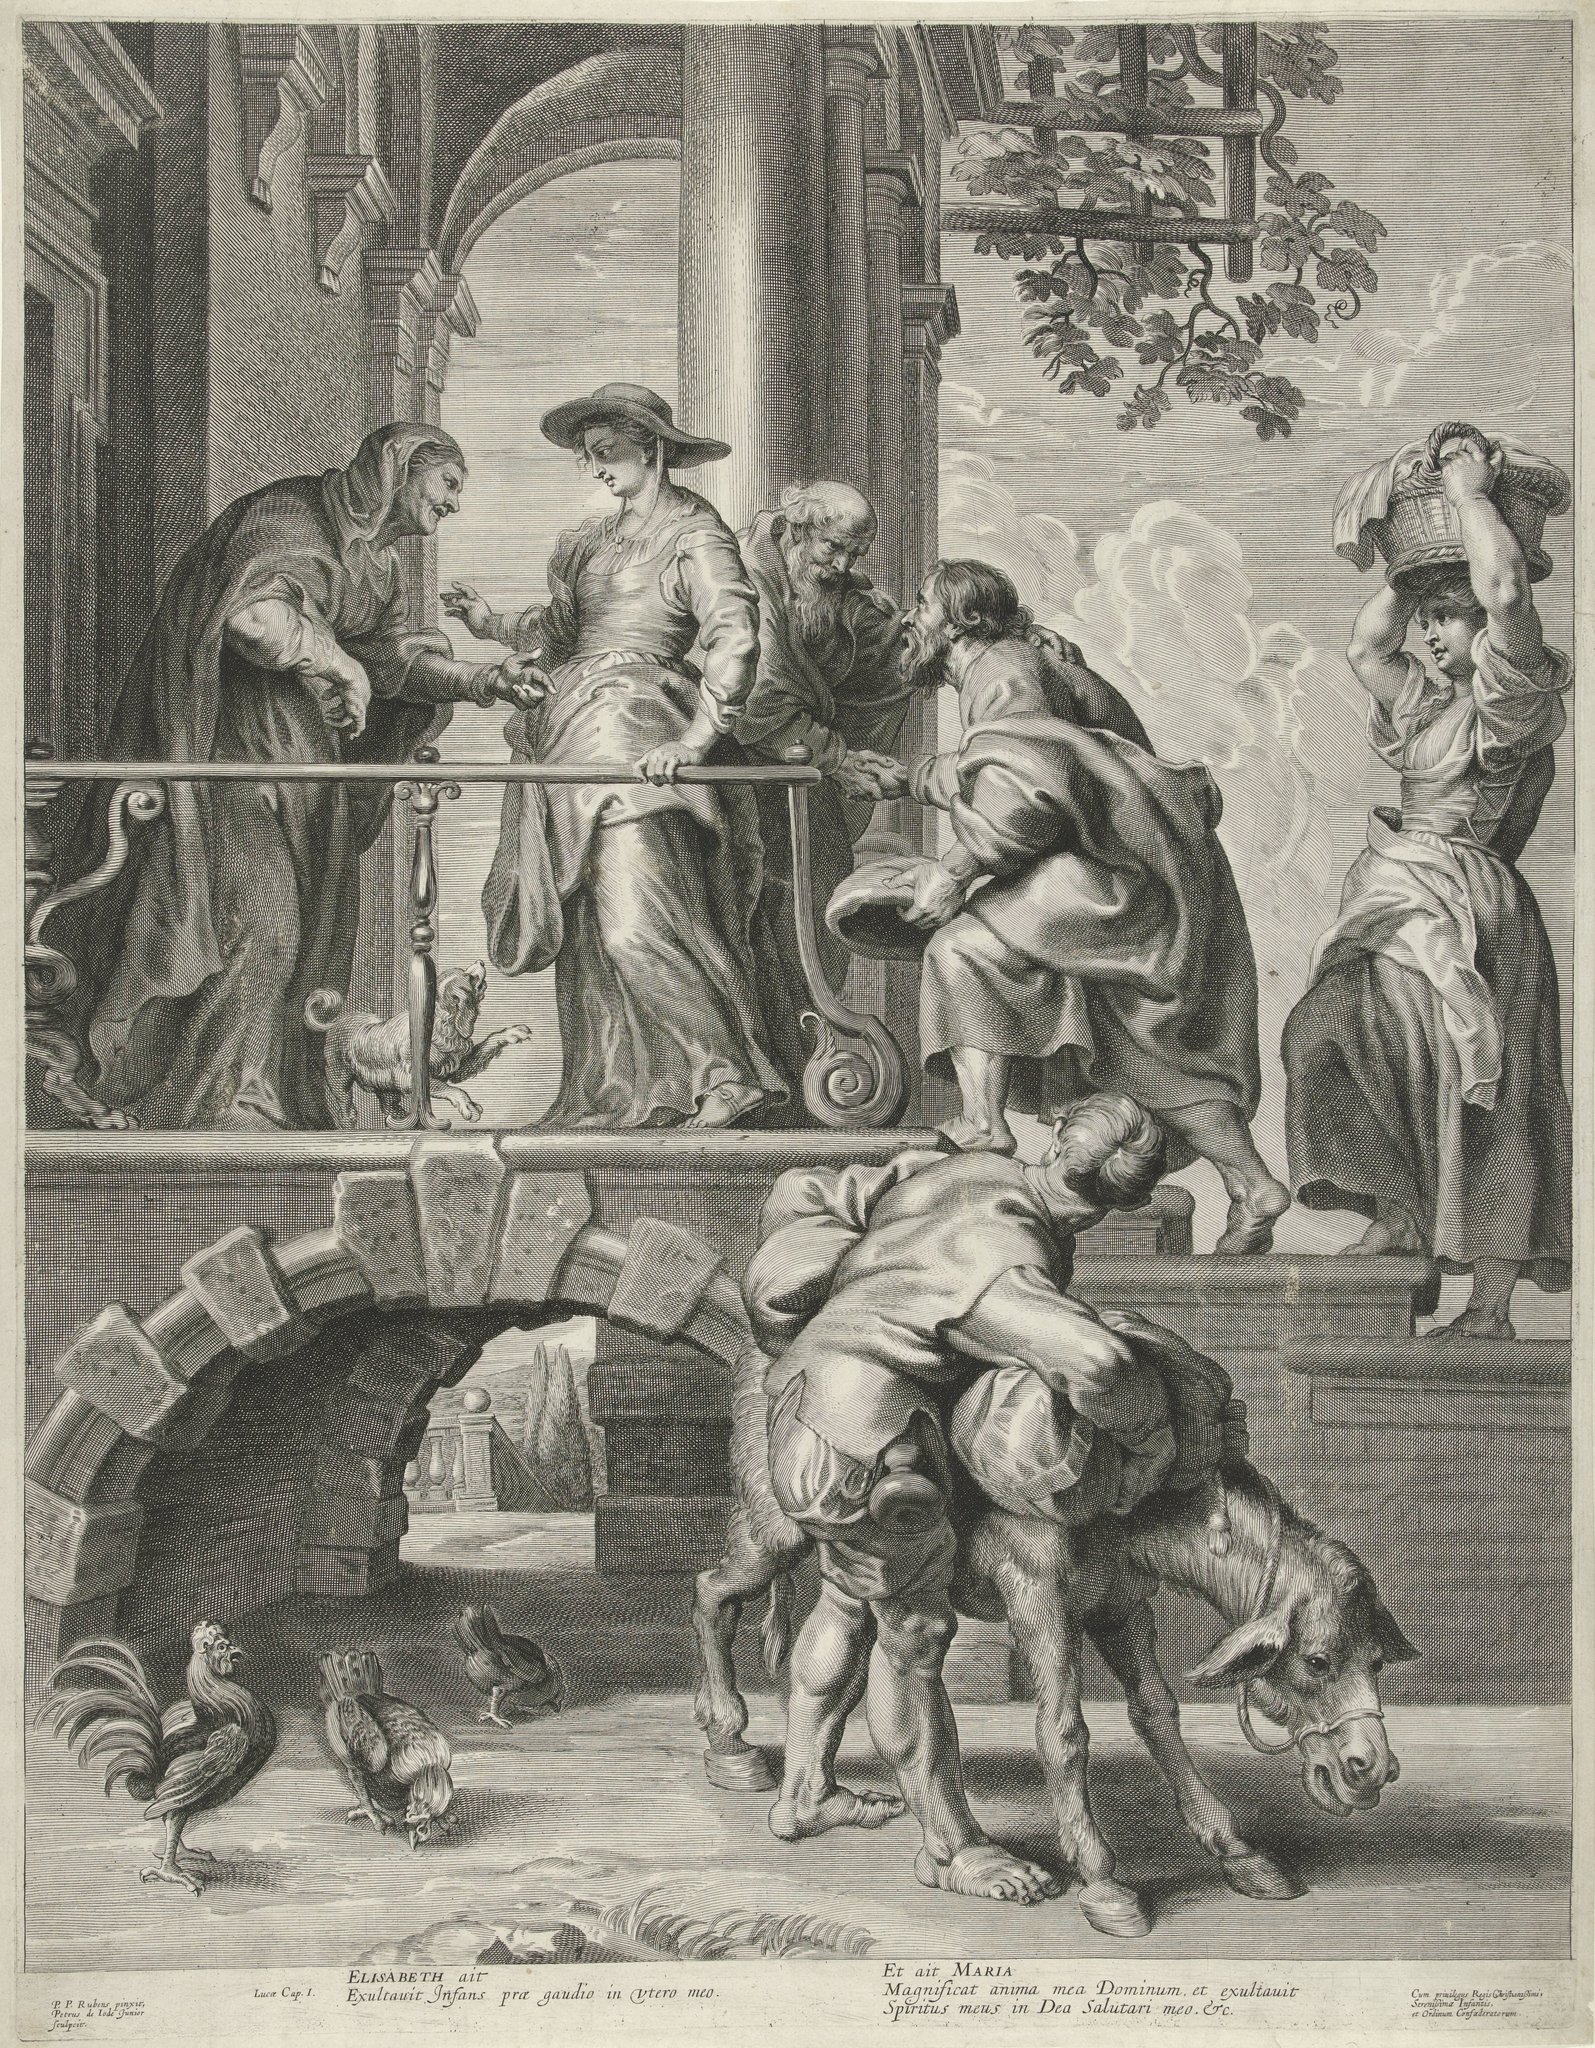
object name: print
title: Visitatie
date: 1628-1670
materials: paper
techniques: engraving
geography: antwerp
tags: visitation (possibly joseph and/or zacharias present) (luke 1:39-56), carrying something on the head or on the shoulders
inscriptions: collector's mark: Lugt 240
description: Het bezoek van Maria aan haar nicht Elisabet. Jozef en Zacharias schudden elkaar de hand. Rechts op de trap staat een vrouw met een mand op haar hoofd. Op de voorgrond een man met een ezel, die naar hen opkijkt. In de marge een Bijbelcitaat uit Luc. 1 in het Latijn.